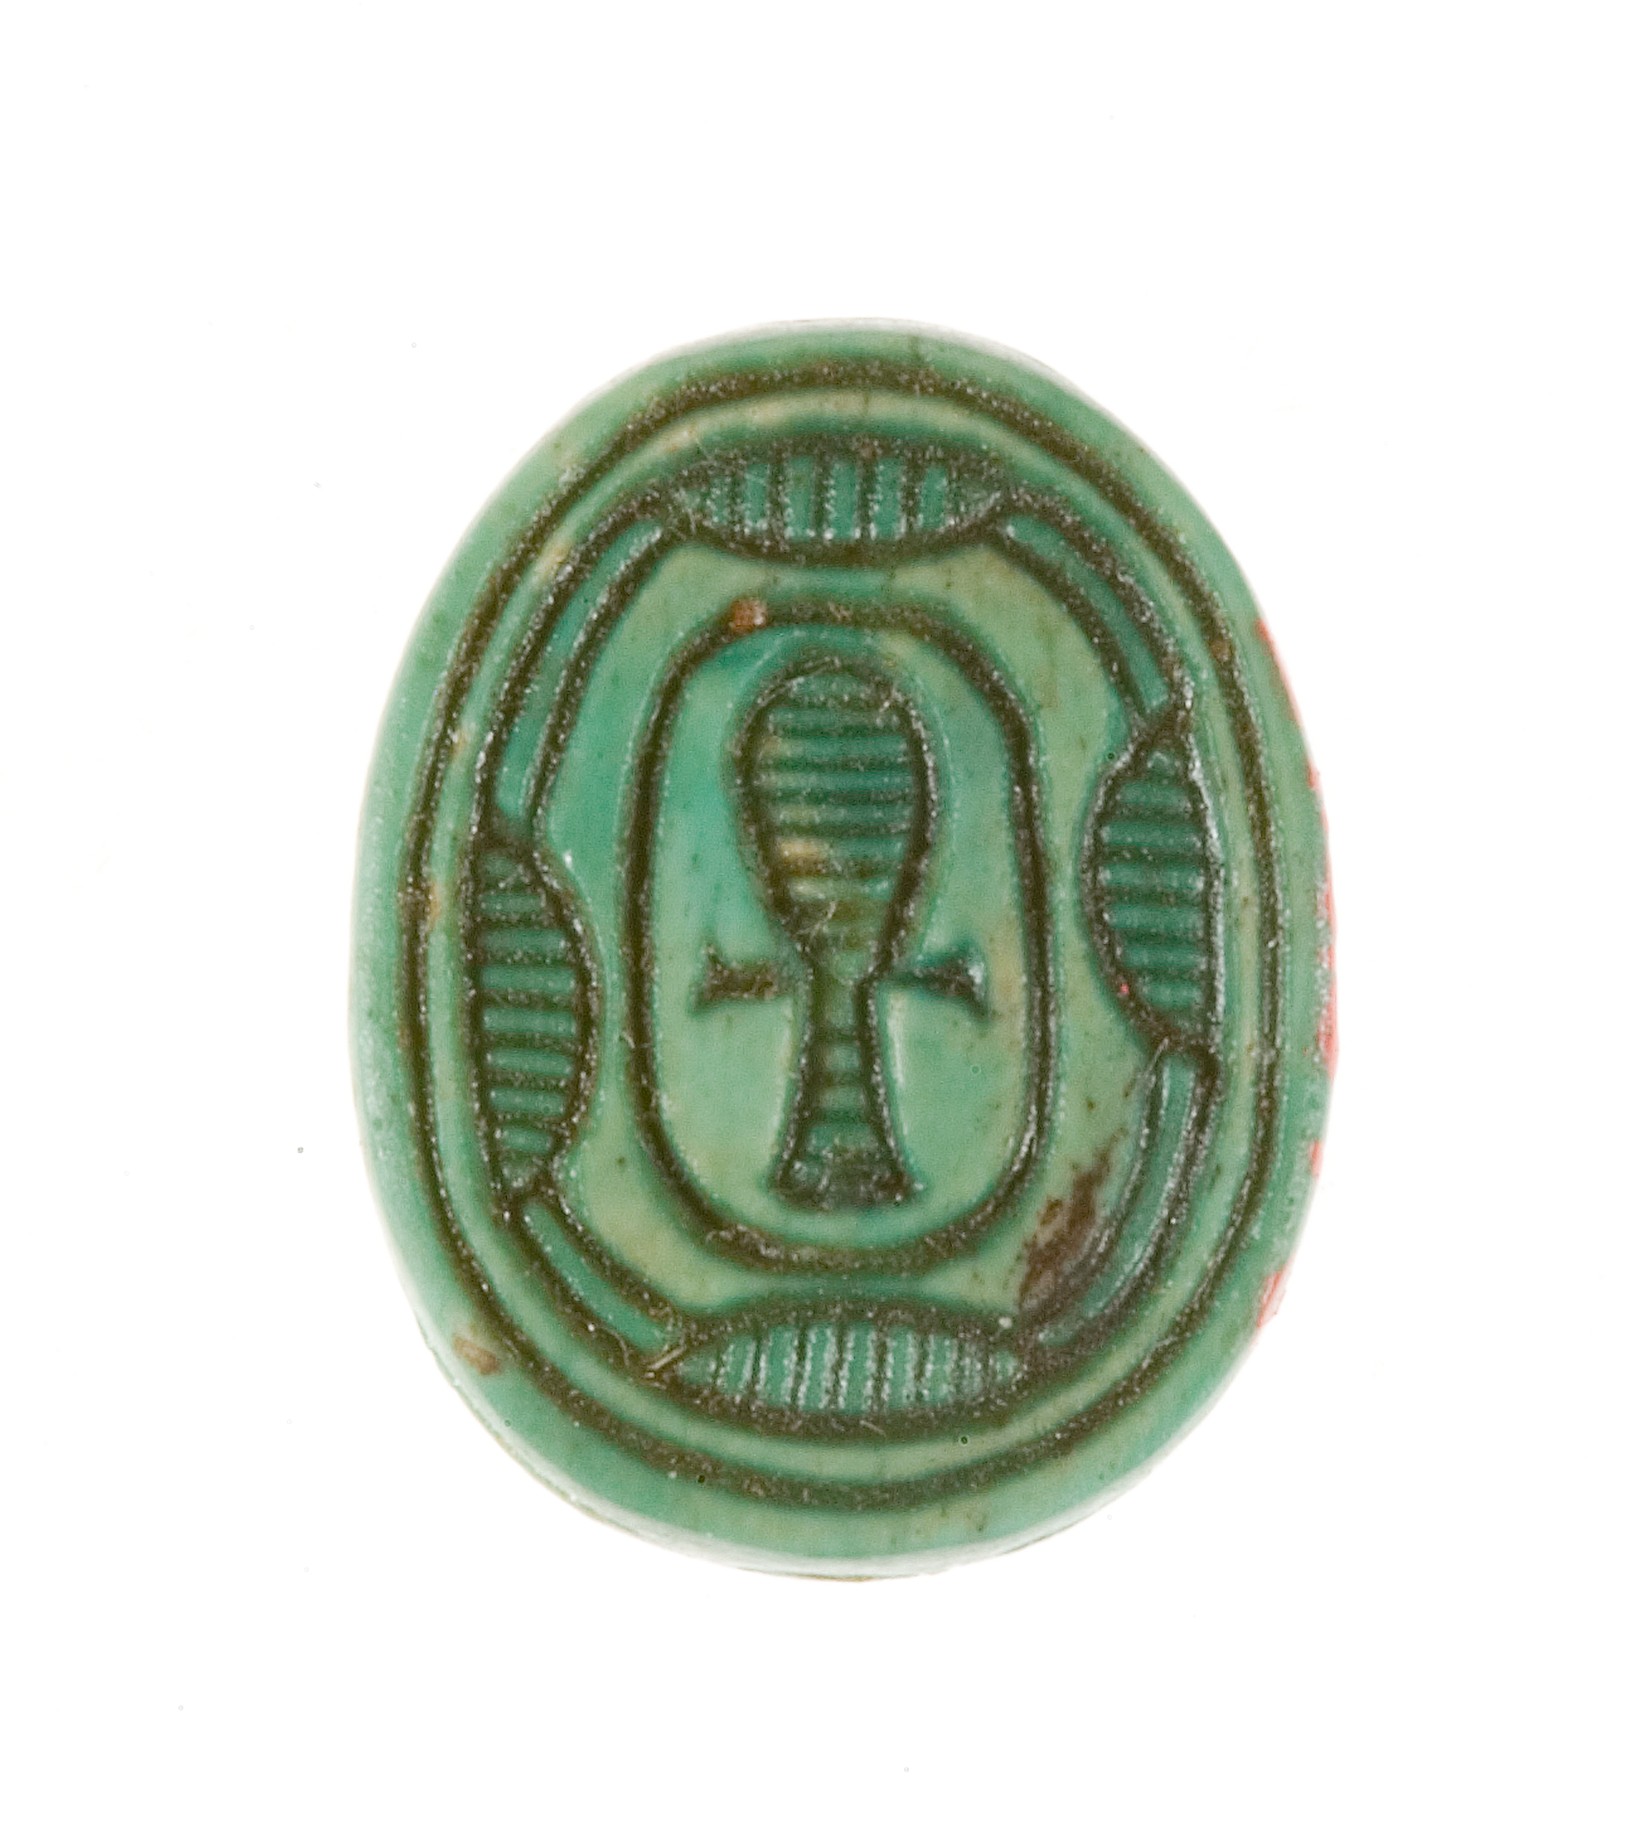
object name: scarab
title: Scarab Inscribed with a Hieroglyphic Motif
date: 1479-1458 BCE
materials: stone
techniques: glazing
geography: egypt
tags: hieroglyphs,scarabs